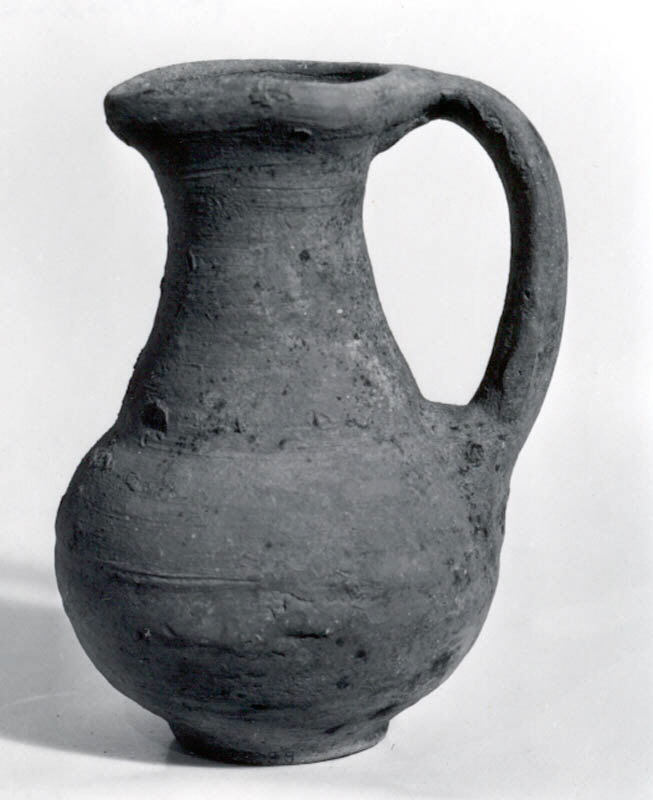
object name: jug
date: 734-601 BCE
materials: ceramic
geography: levant